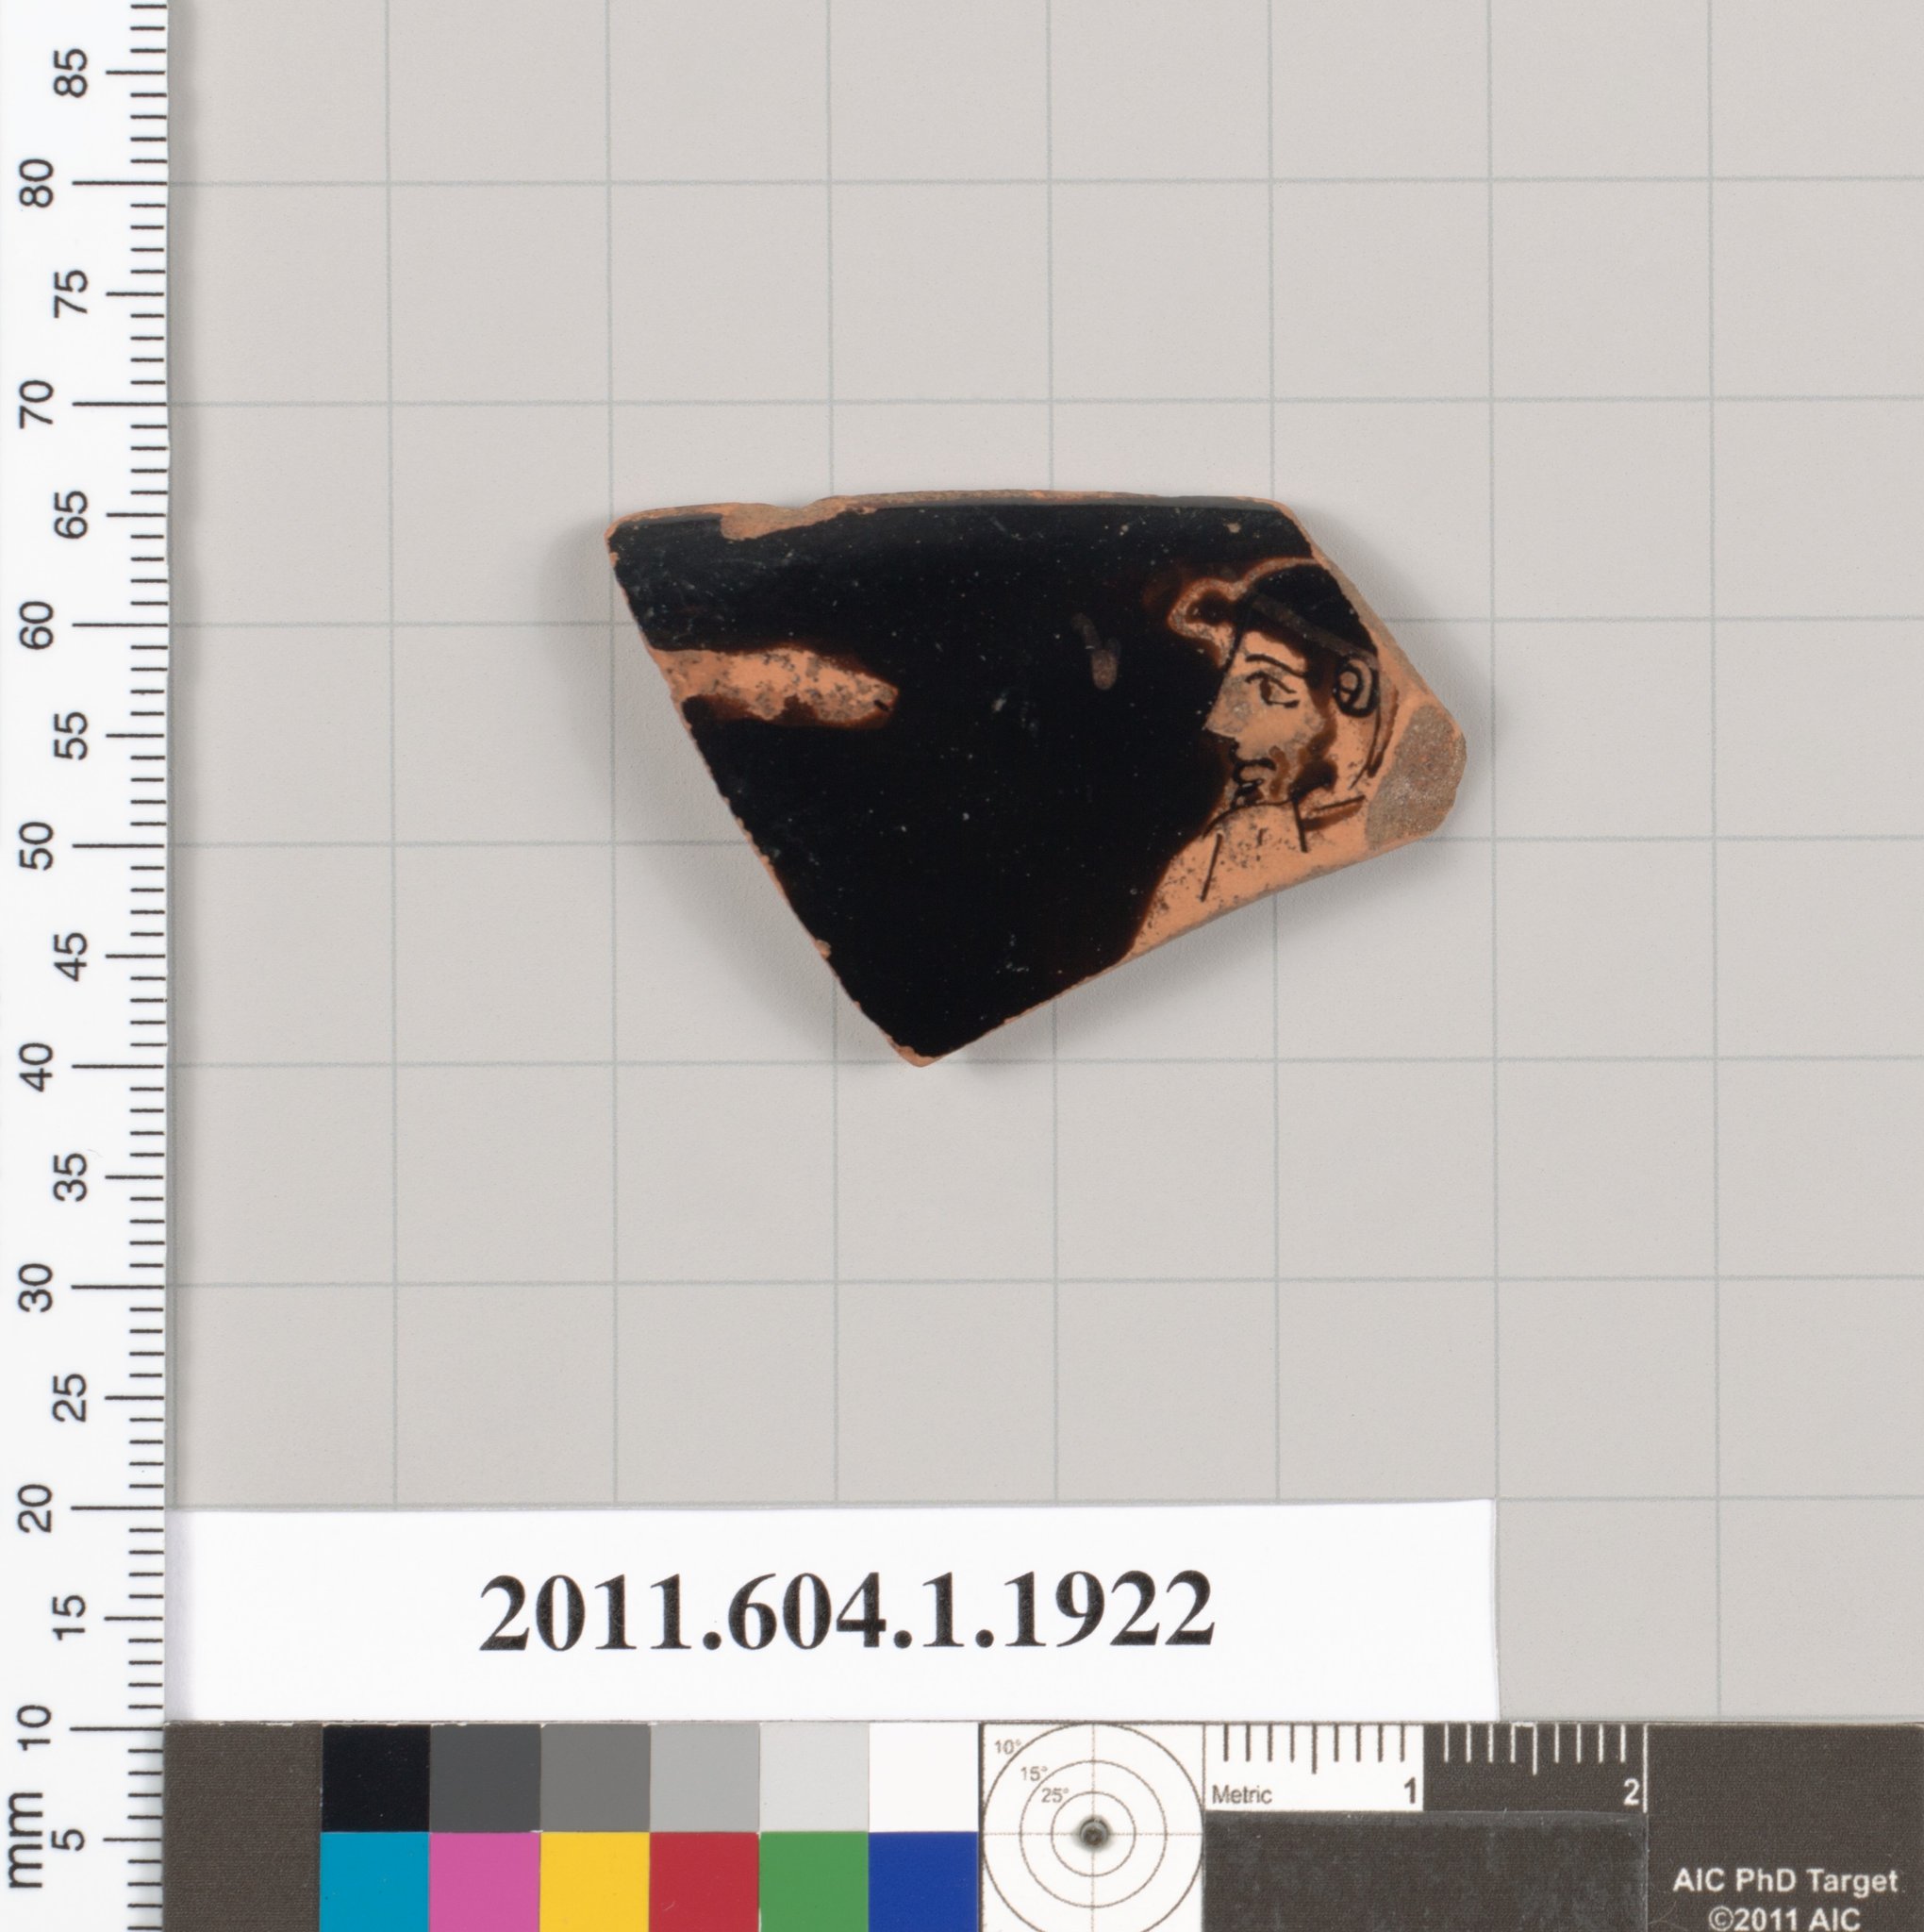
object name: kylix fragment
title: Terracotta rim fragment of a kylix (drinking cup)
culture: greek, attic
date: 475-451 BCE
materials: terracotta